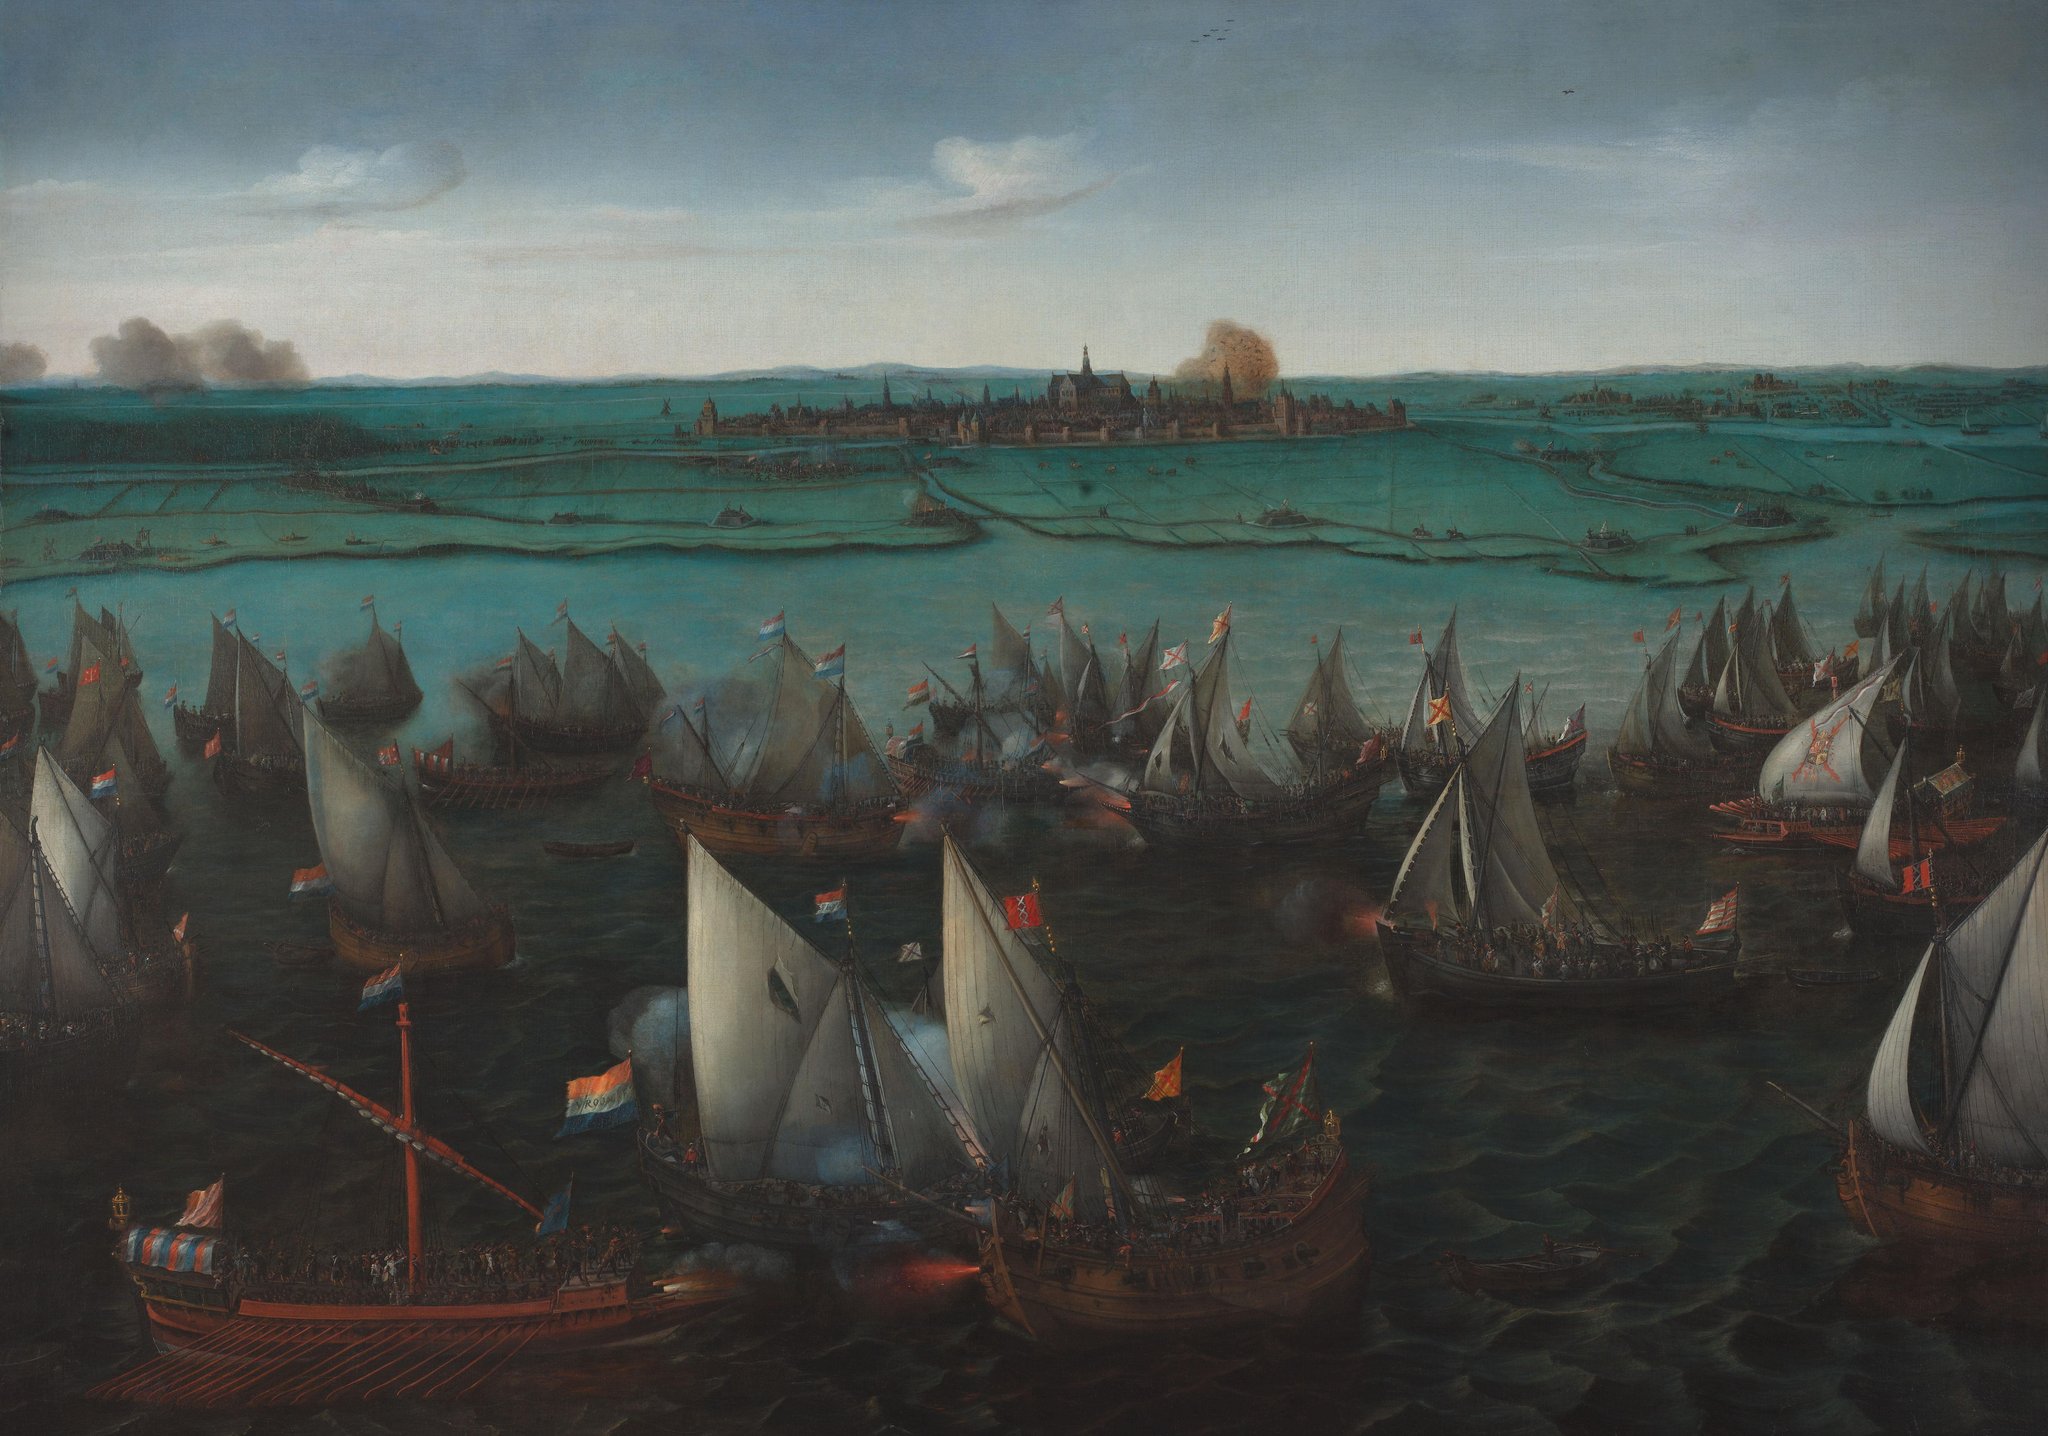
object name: painting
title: Battle between Dutch and Spanish Ships on the Haarlemmermeer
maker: hendrick cornelisz vroom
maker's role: draughtsman, painter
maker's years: 1566-1640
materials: canvas, oil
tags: city-view in general; 'veduta', battle (+ naval force), lake, haarlem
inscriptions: signature, on a flag on one of the ships on the left: ‘VROOM F.’, date, on a flag of one of the ships: ‘16..’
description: When Haarlem sided with the Dutch Revolt in 1572, the Spanish lay siege to the city. In May 1573, the rebels attempted to recapture the Haarlemmermeer, which was a major supply channel to the city. They were defeated by a fleet of Spanish and Amsterdam ships (Amsterdam was then still loyal to Spain). Haarlem was ultimately forced to surrender to the Spanish.